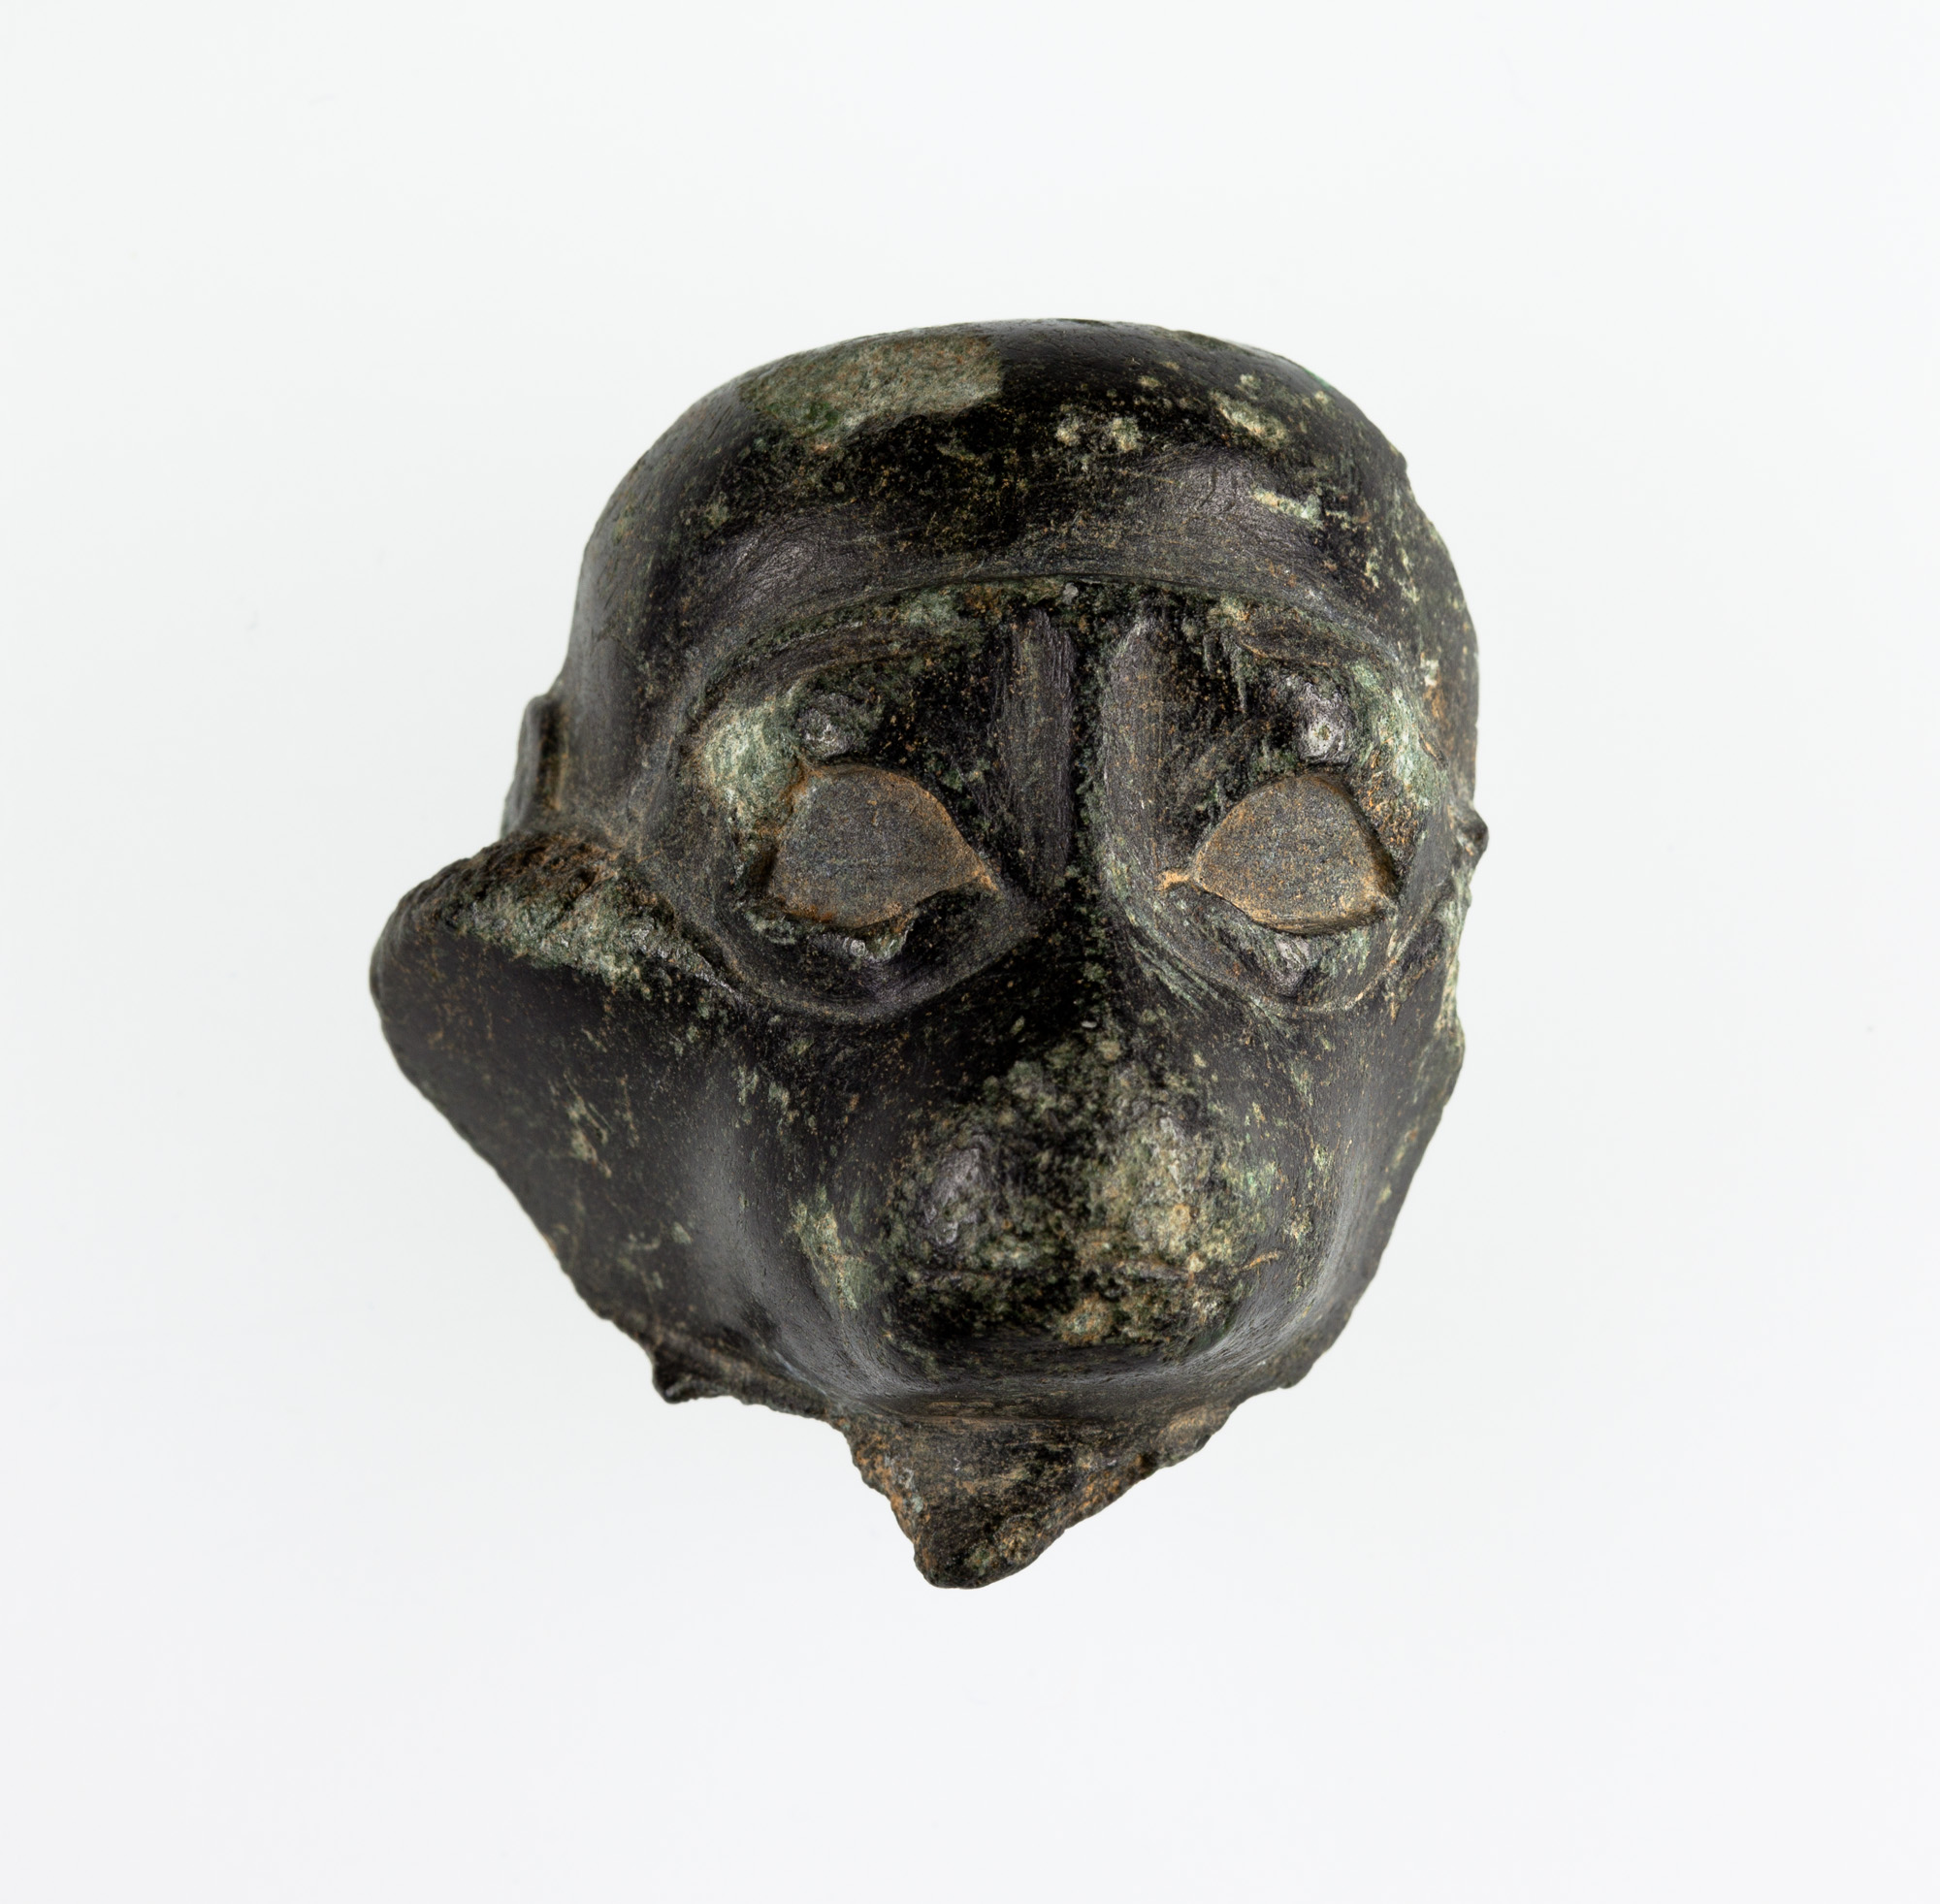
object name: ointment jar fragment, monkey head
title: Head of a monkey from an ointment vessel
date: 2323-2150 BCE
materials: stone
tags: monkeys